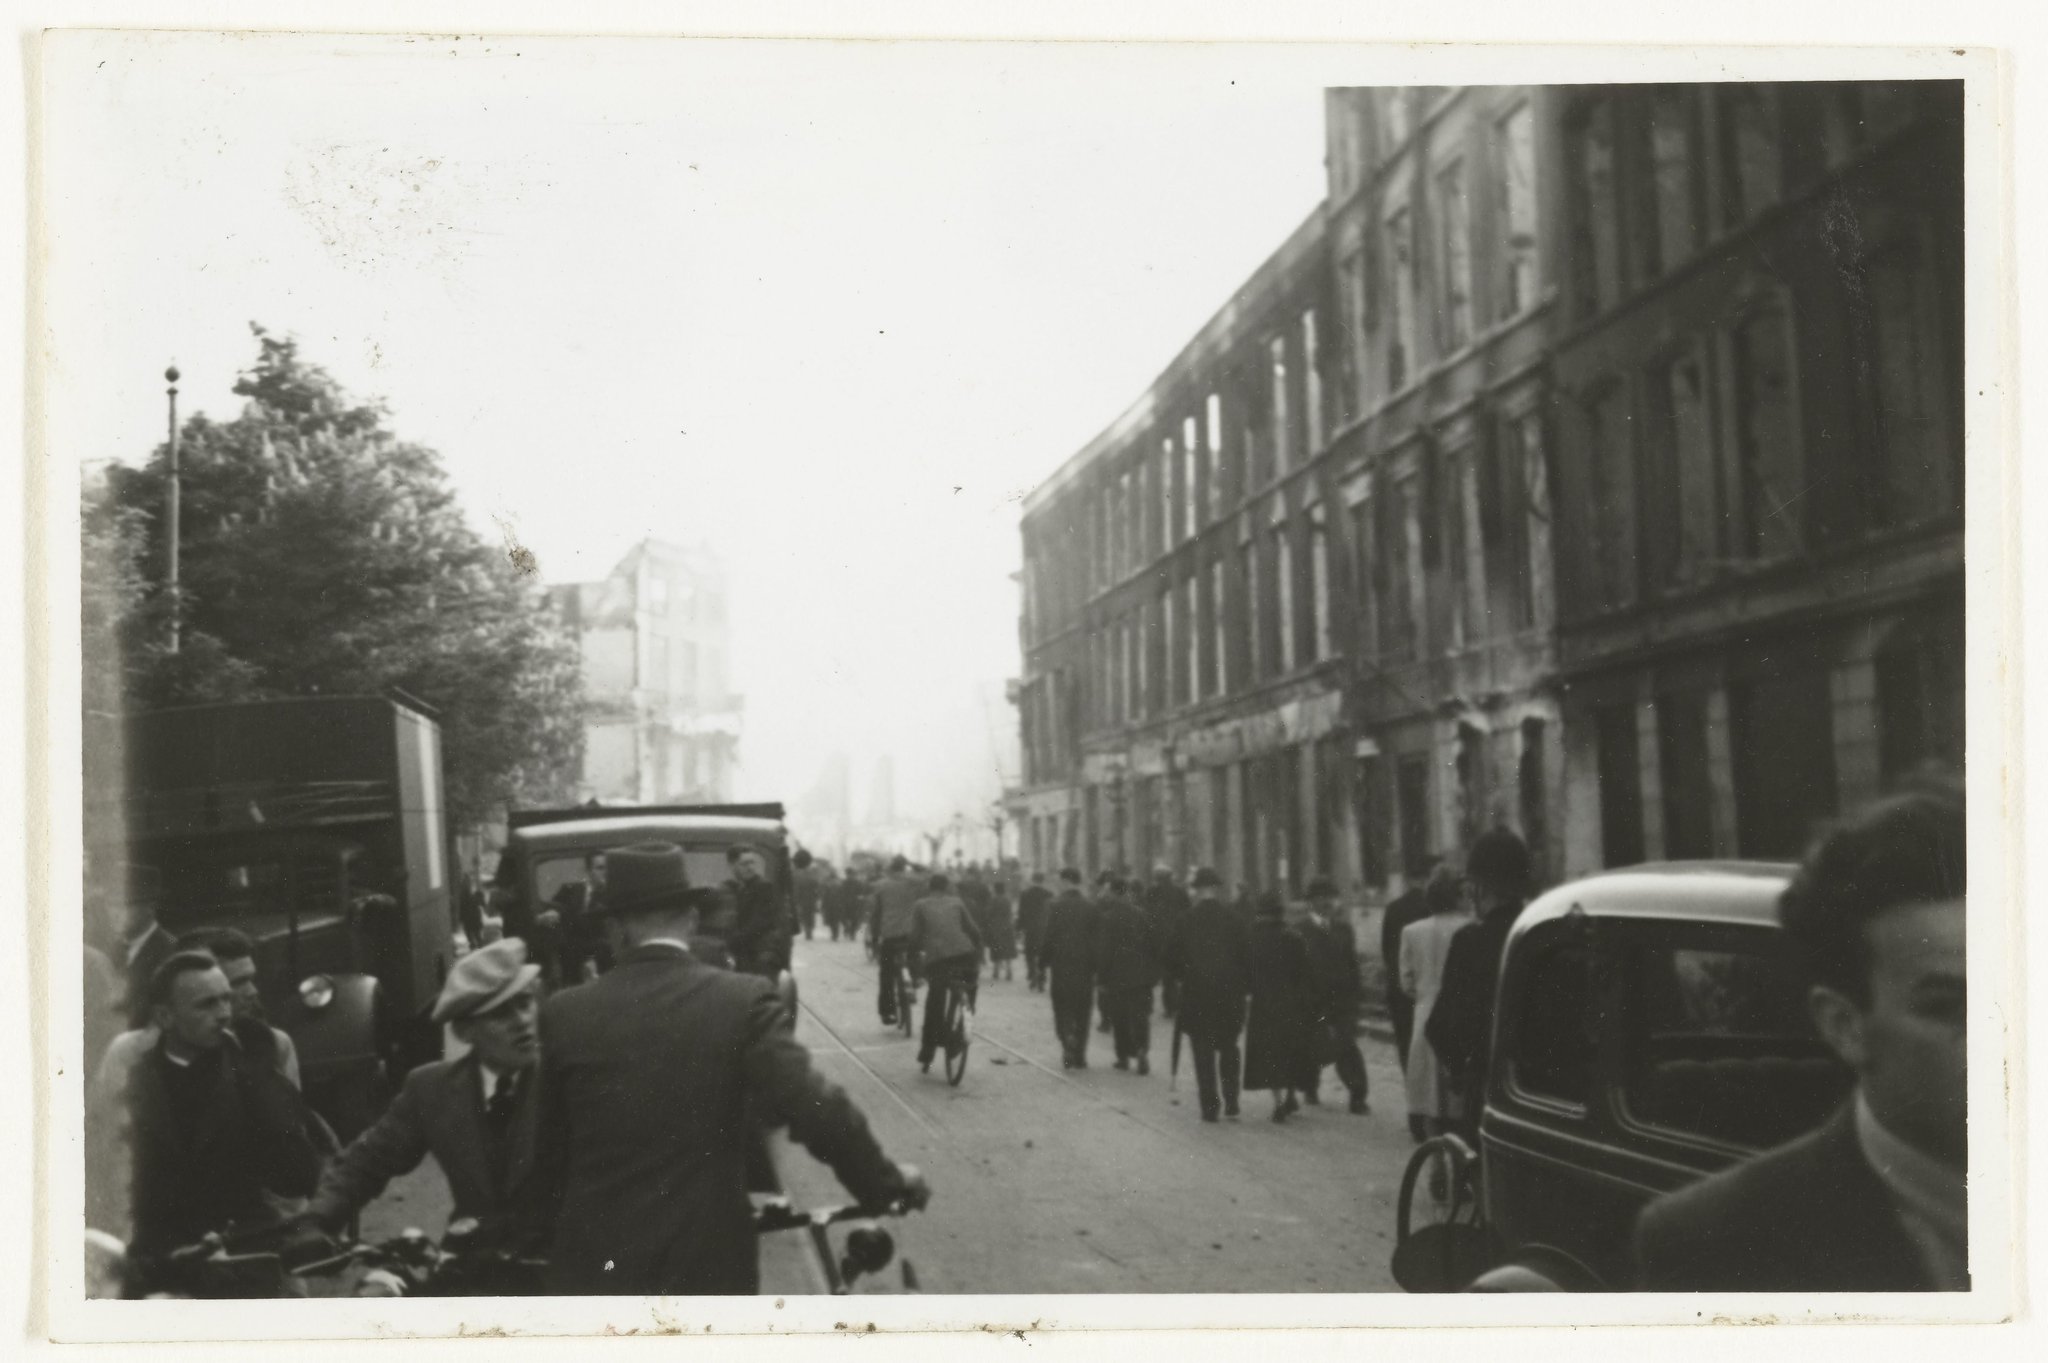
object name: photograph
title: Uitgebrande huizen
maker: Anonymous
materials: photographic support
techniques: gelatin silver print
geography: netherlands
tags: devastated, ruined place or city (~ warfare), occupation ~ war, netherlands, rotterdam, rotterdam blitz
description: Uitgebrande huizen in een straat vol mensen en auto's. Het zou Rotterdam kunnen zijn.